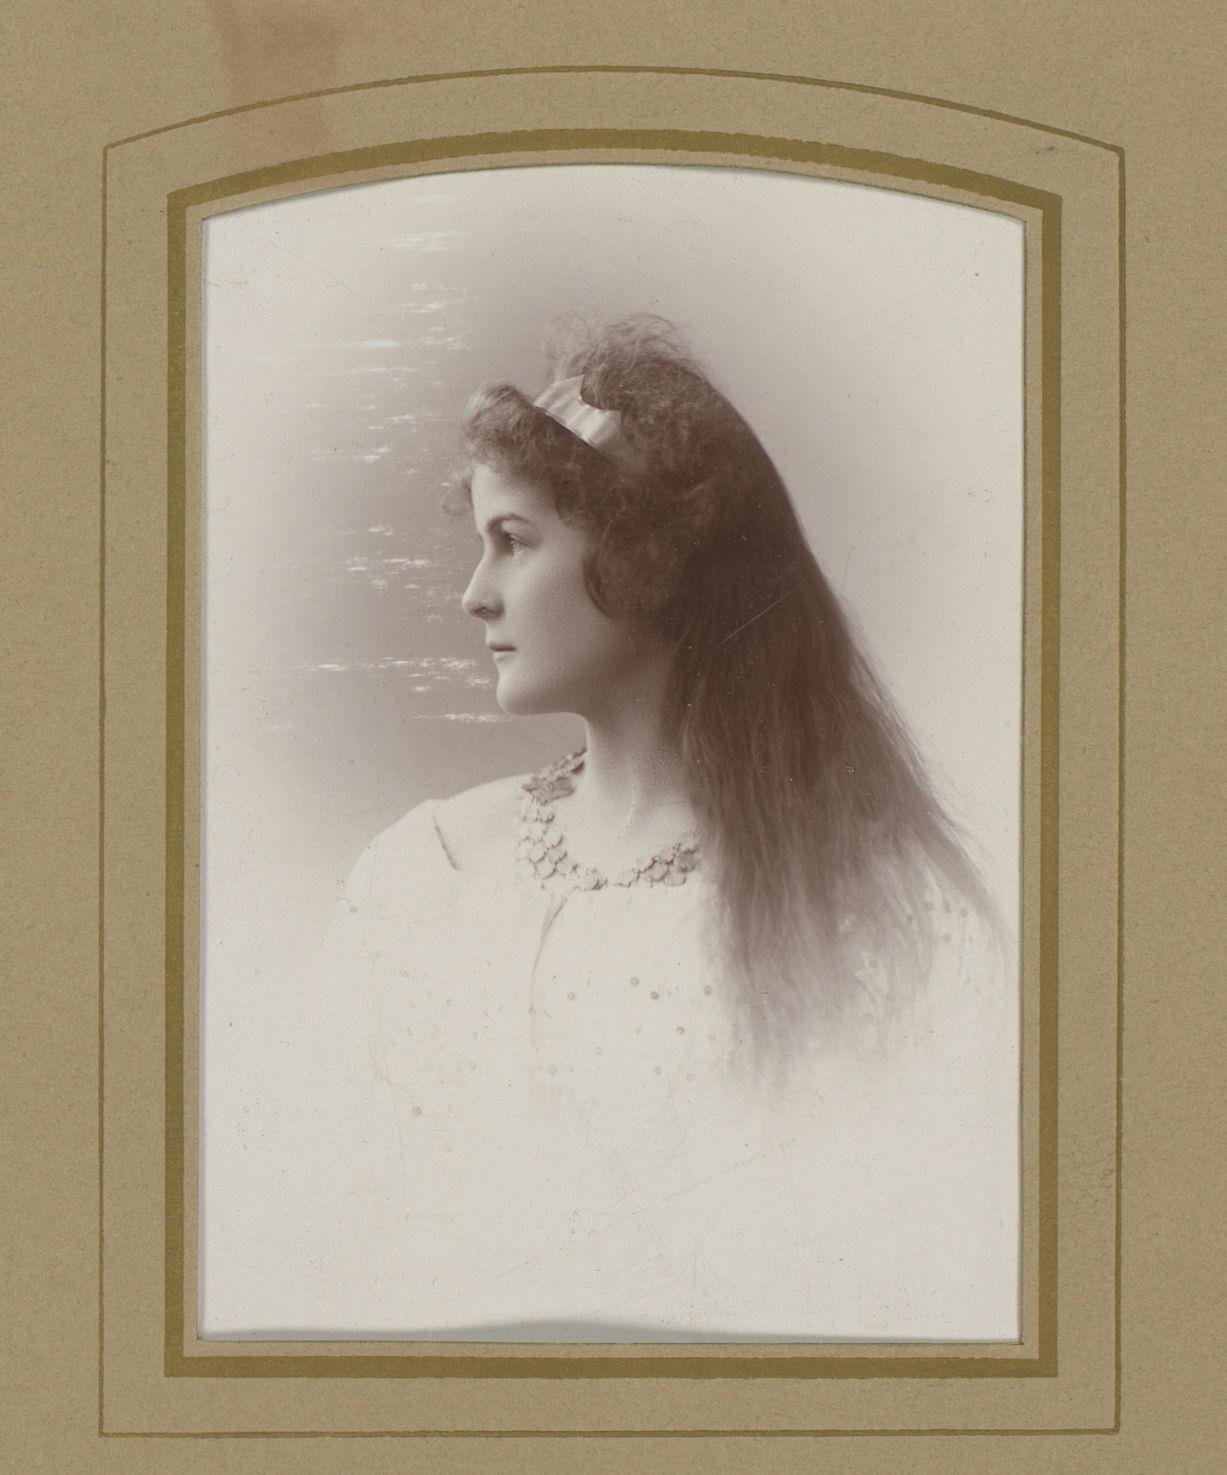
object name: photograph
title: Portret van een vrouw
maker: henri de louw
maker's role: fotograaf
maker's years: 1851-1944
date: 1871-1875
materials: cardboard, photographic support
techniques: collodion silver print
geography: the hague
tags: historical persons - bb - woman